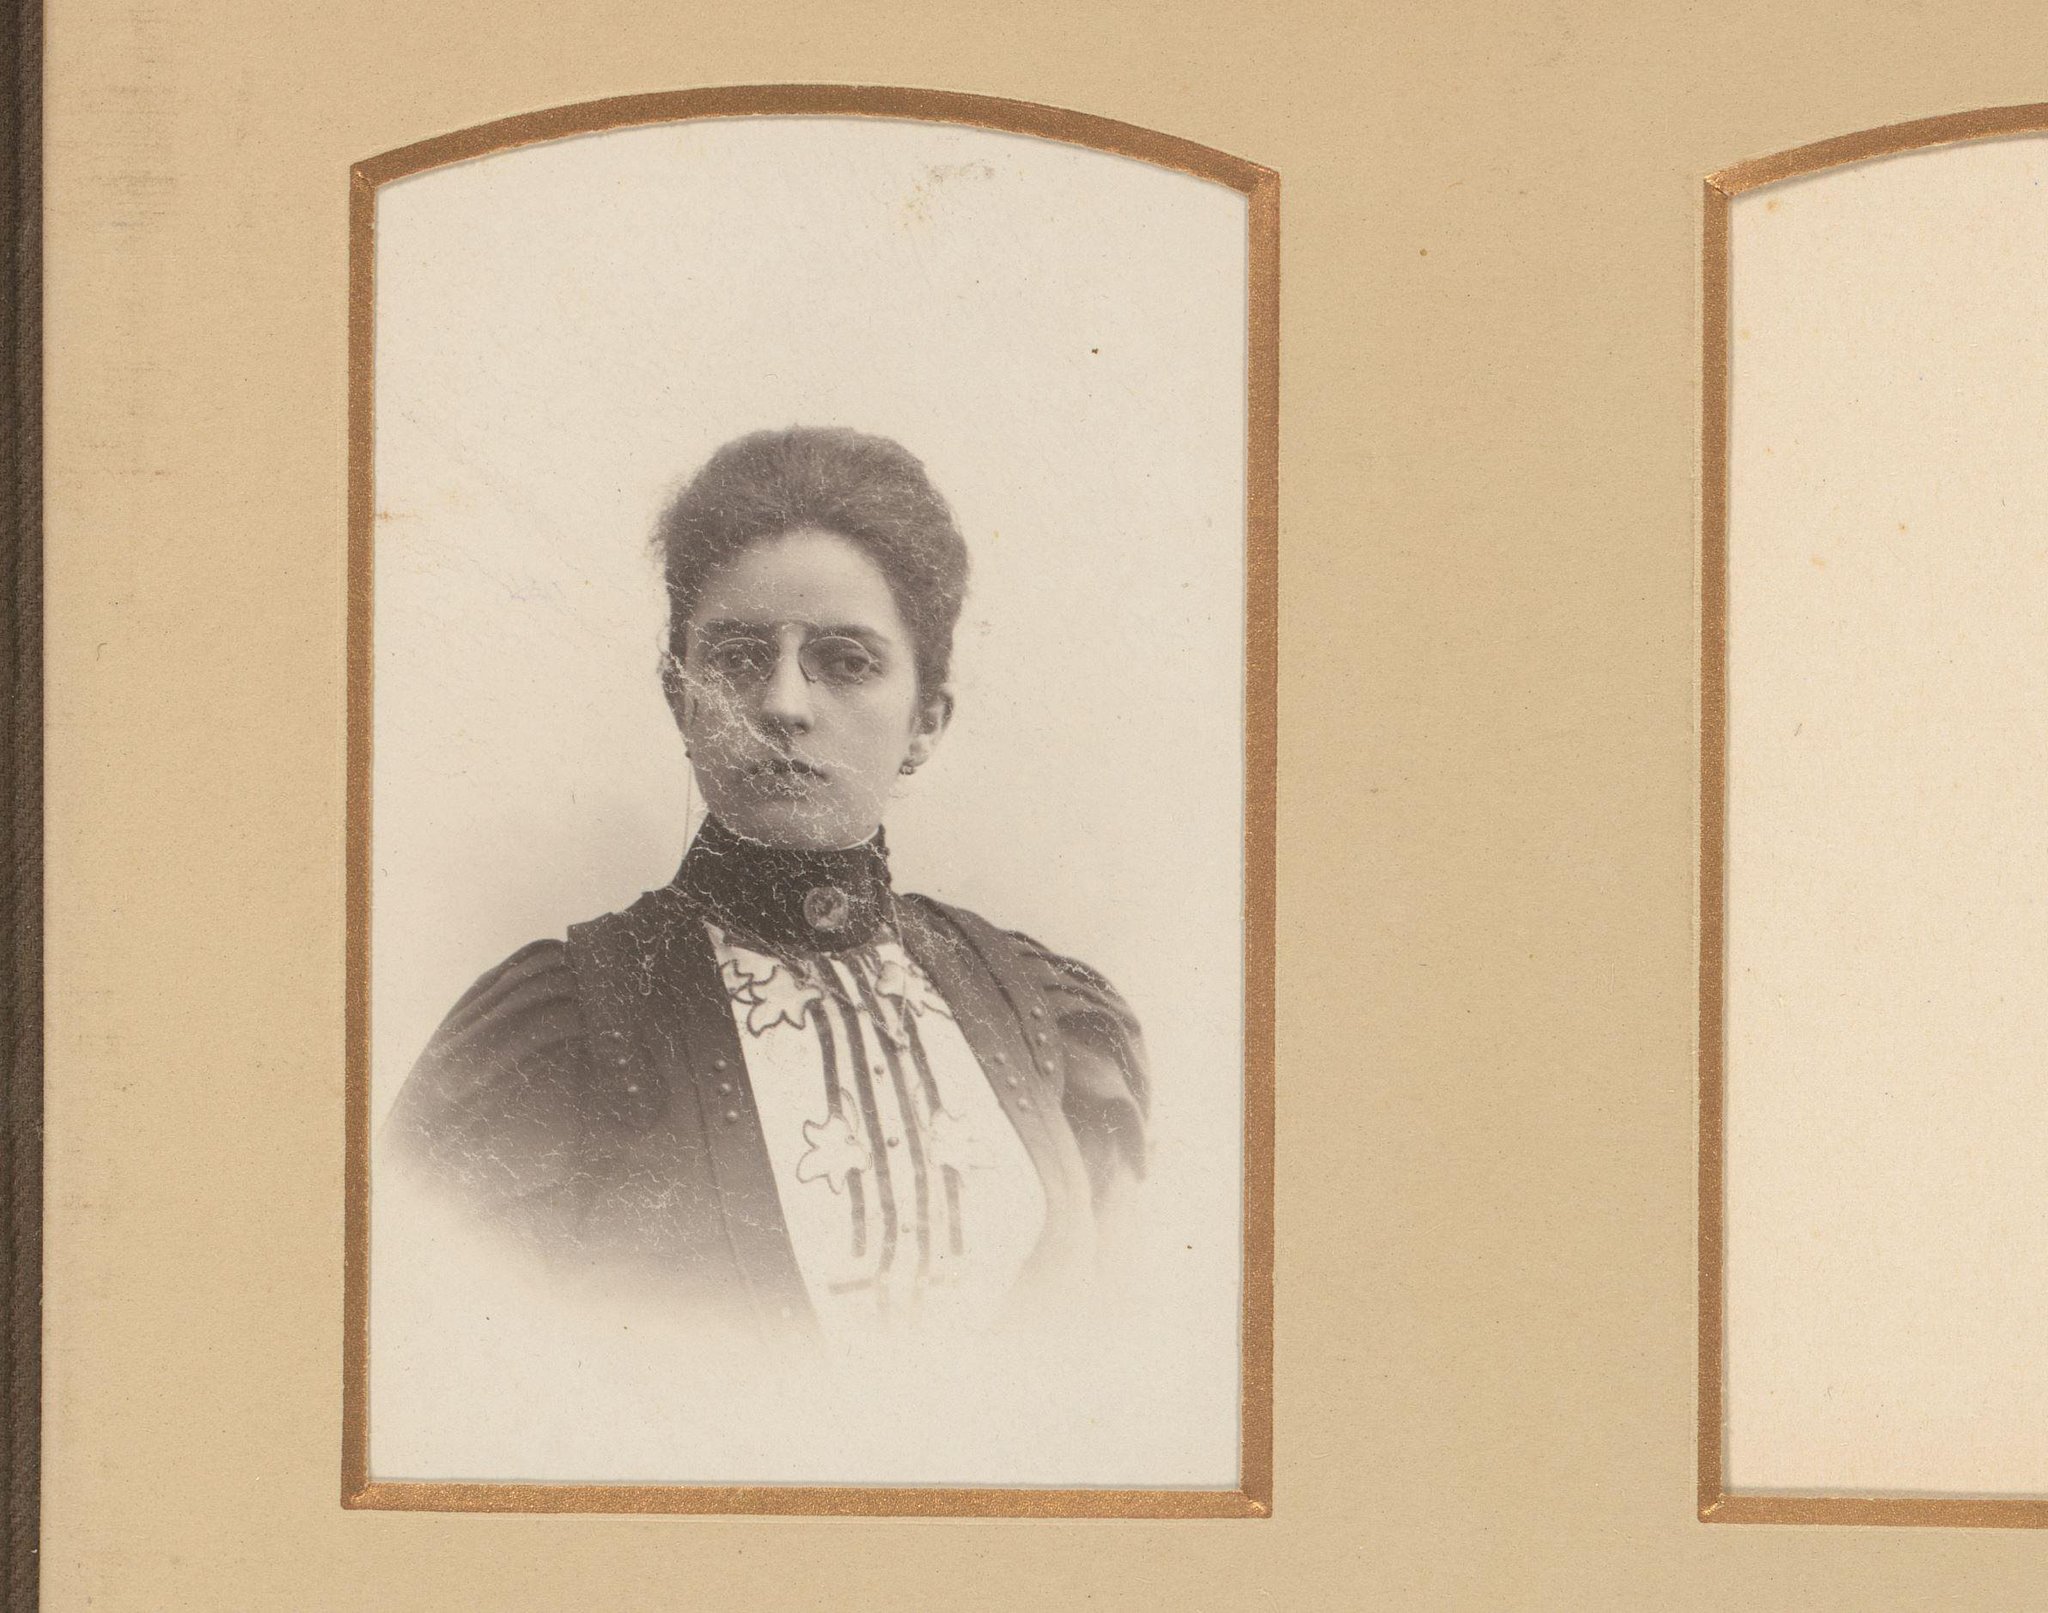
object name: photograph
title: Portret van een vrouw met bril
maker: guillame maximilien zimmermann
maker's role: fotograaf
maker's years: 1873-1951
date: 1897-1902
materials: cardboard, photographic support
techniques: matte daylight collodion silver print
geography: amsterdam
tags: eyeglasses, spectacles, historical persons - bb - woman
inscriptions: inscription: ‘Willy Zimmermann/ AMSTERDAM/ Const. Huijg. Str. 49.’